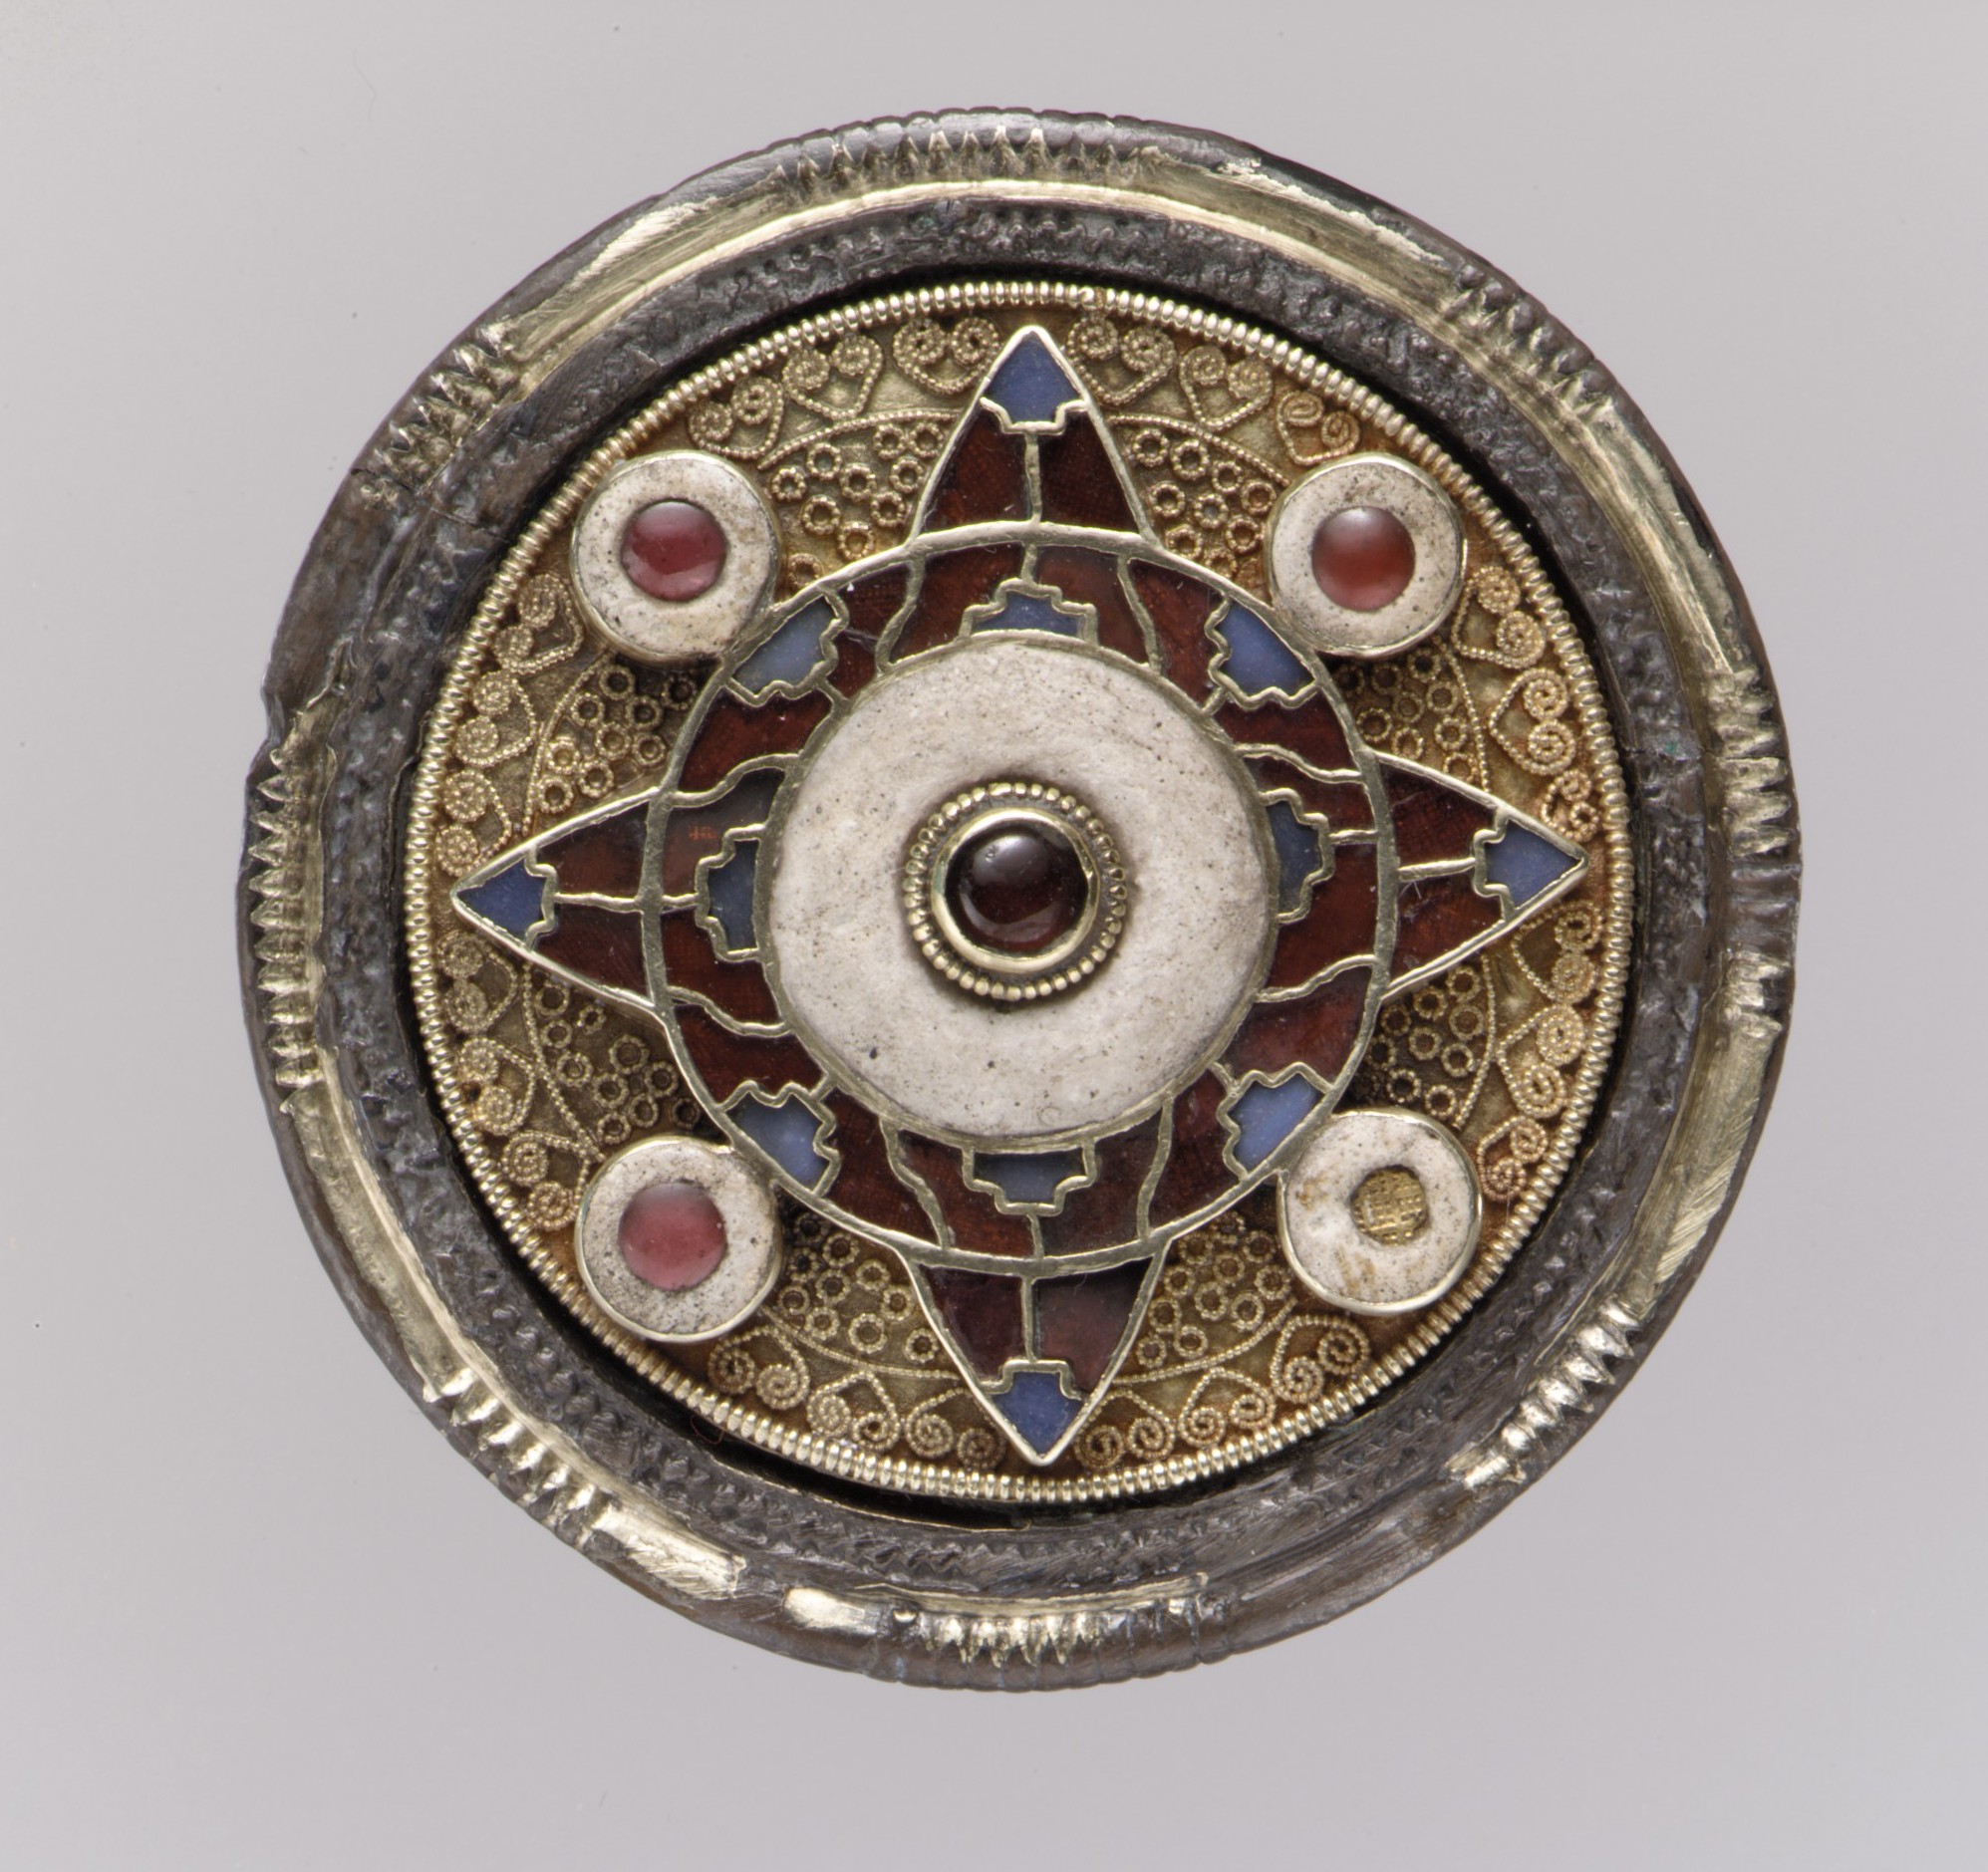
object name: brooch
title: Disk Brooch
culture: anglo-saxon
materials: garnet, glass, gold, niello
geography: england